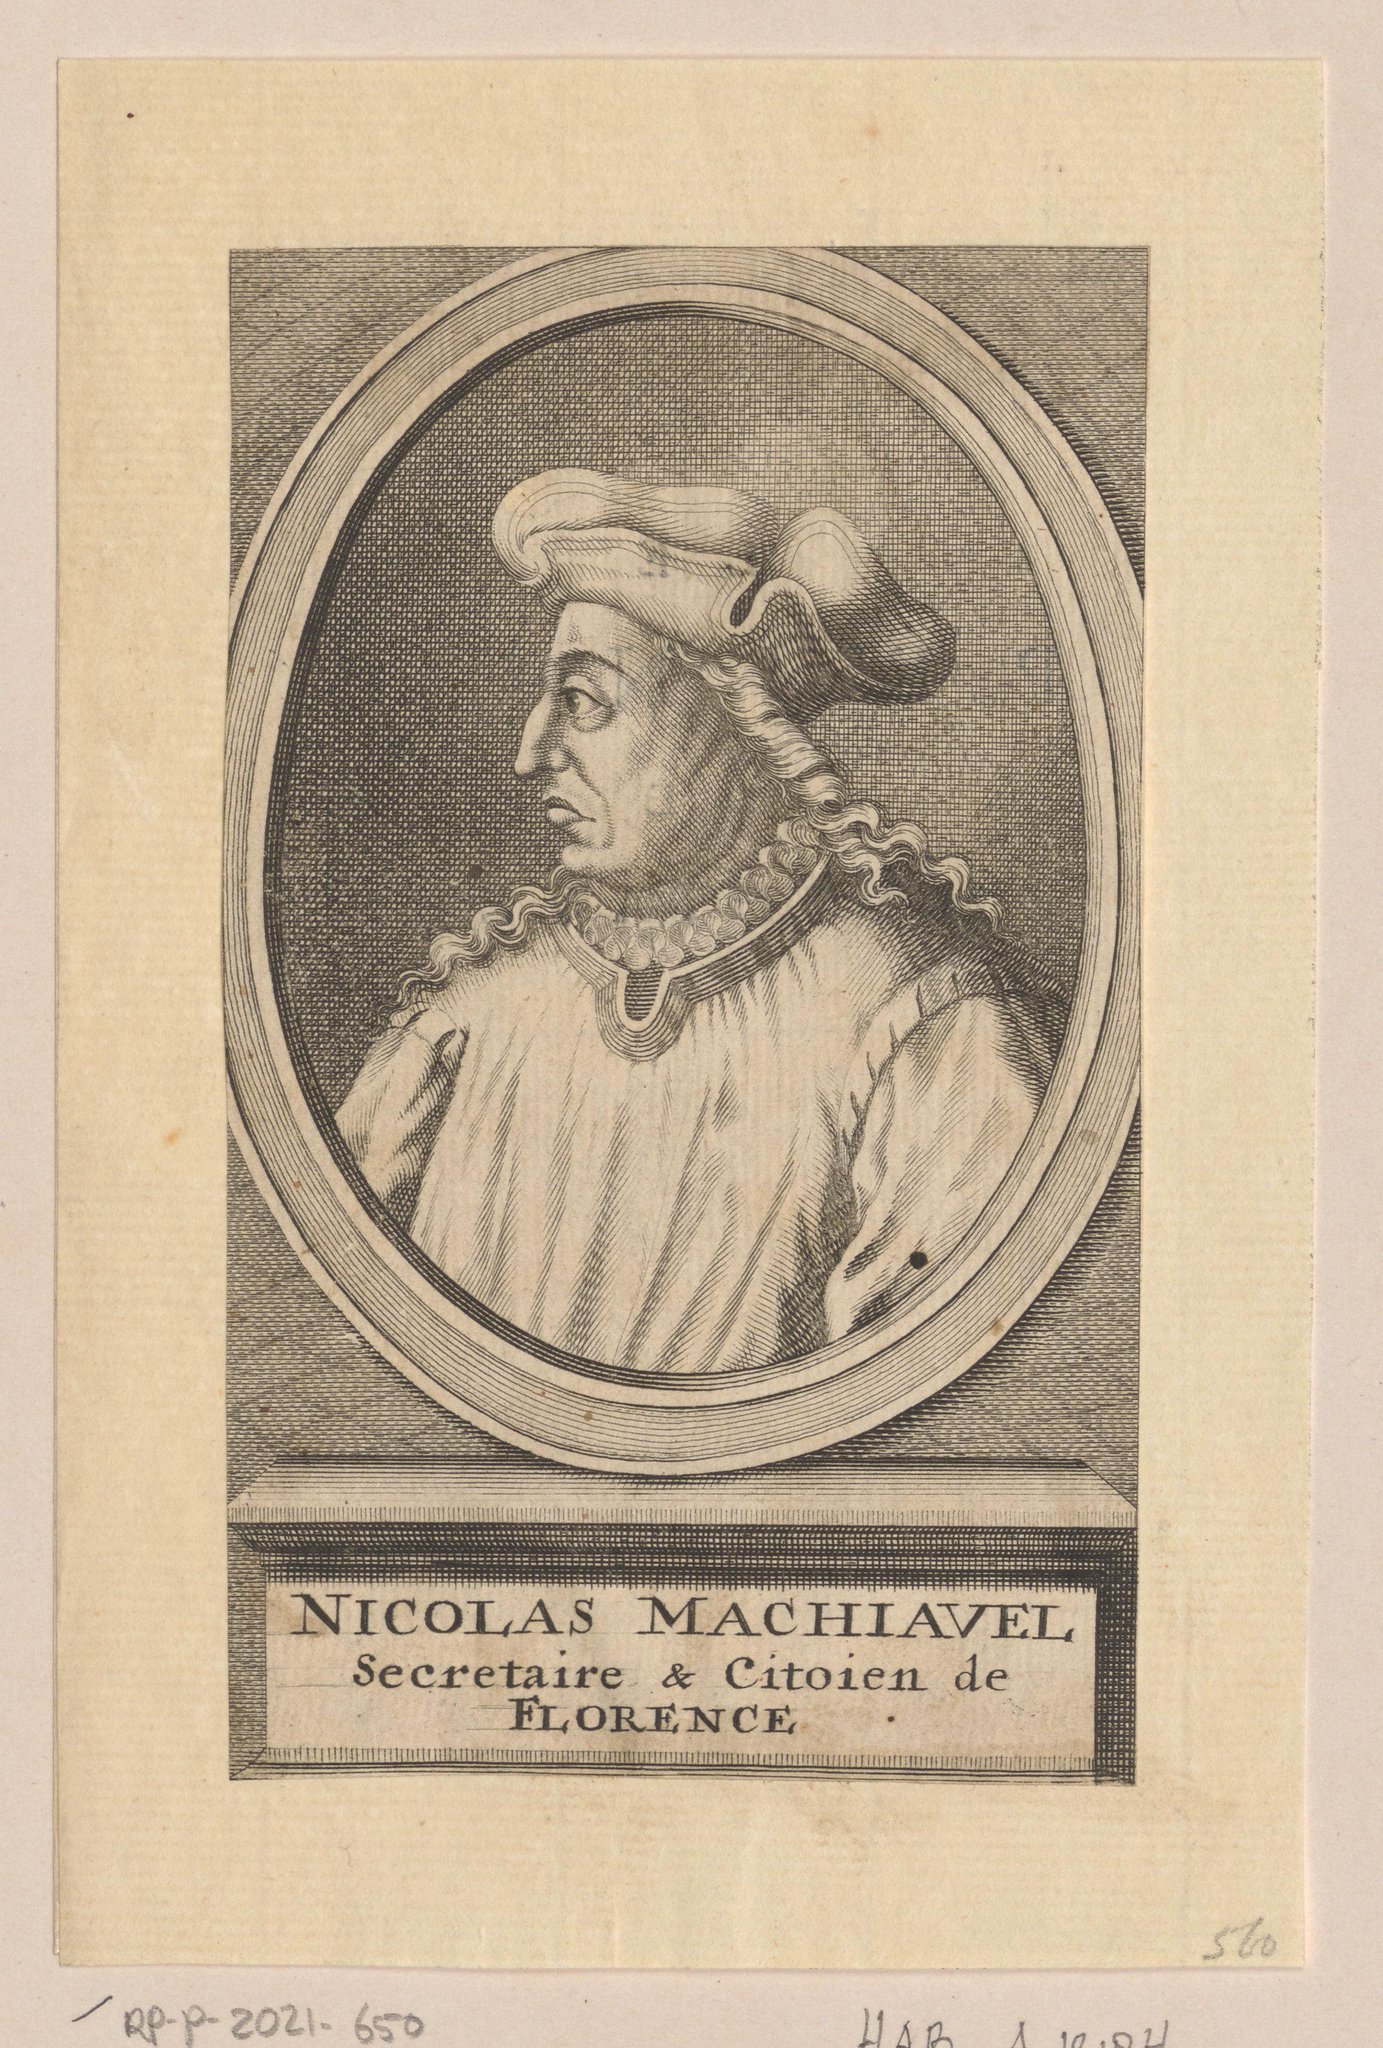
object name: print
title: Portret van Niccolò Machiavelli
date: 1683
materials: paper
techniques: engraving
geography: amsterdam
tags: historical persons, scholar, philosopher (+ portrait of scholar, scientist)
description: Prent uit: Macchiavelli, Niccolò. Le prince de Nicolas Machiavel: citoien et secretaire de Florence. Amsterdam: Henry Wetstein, 1684.